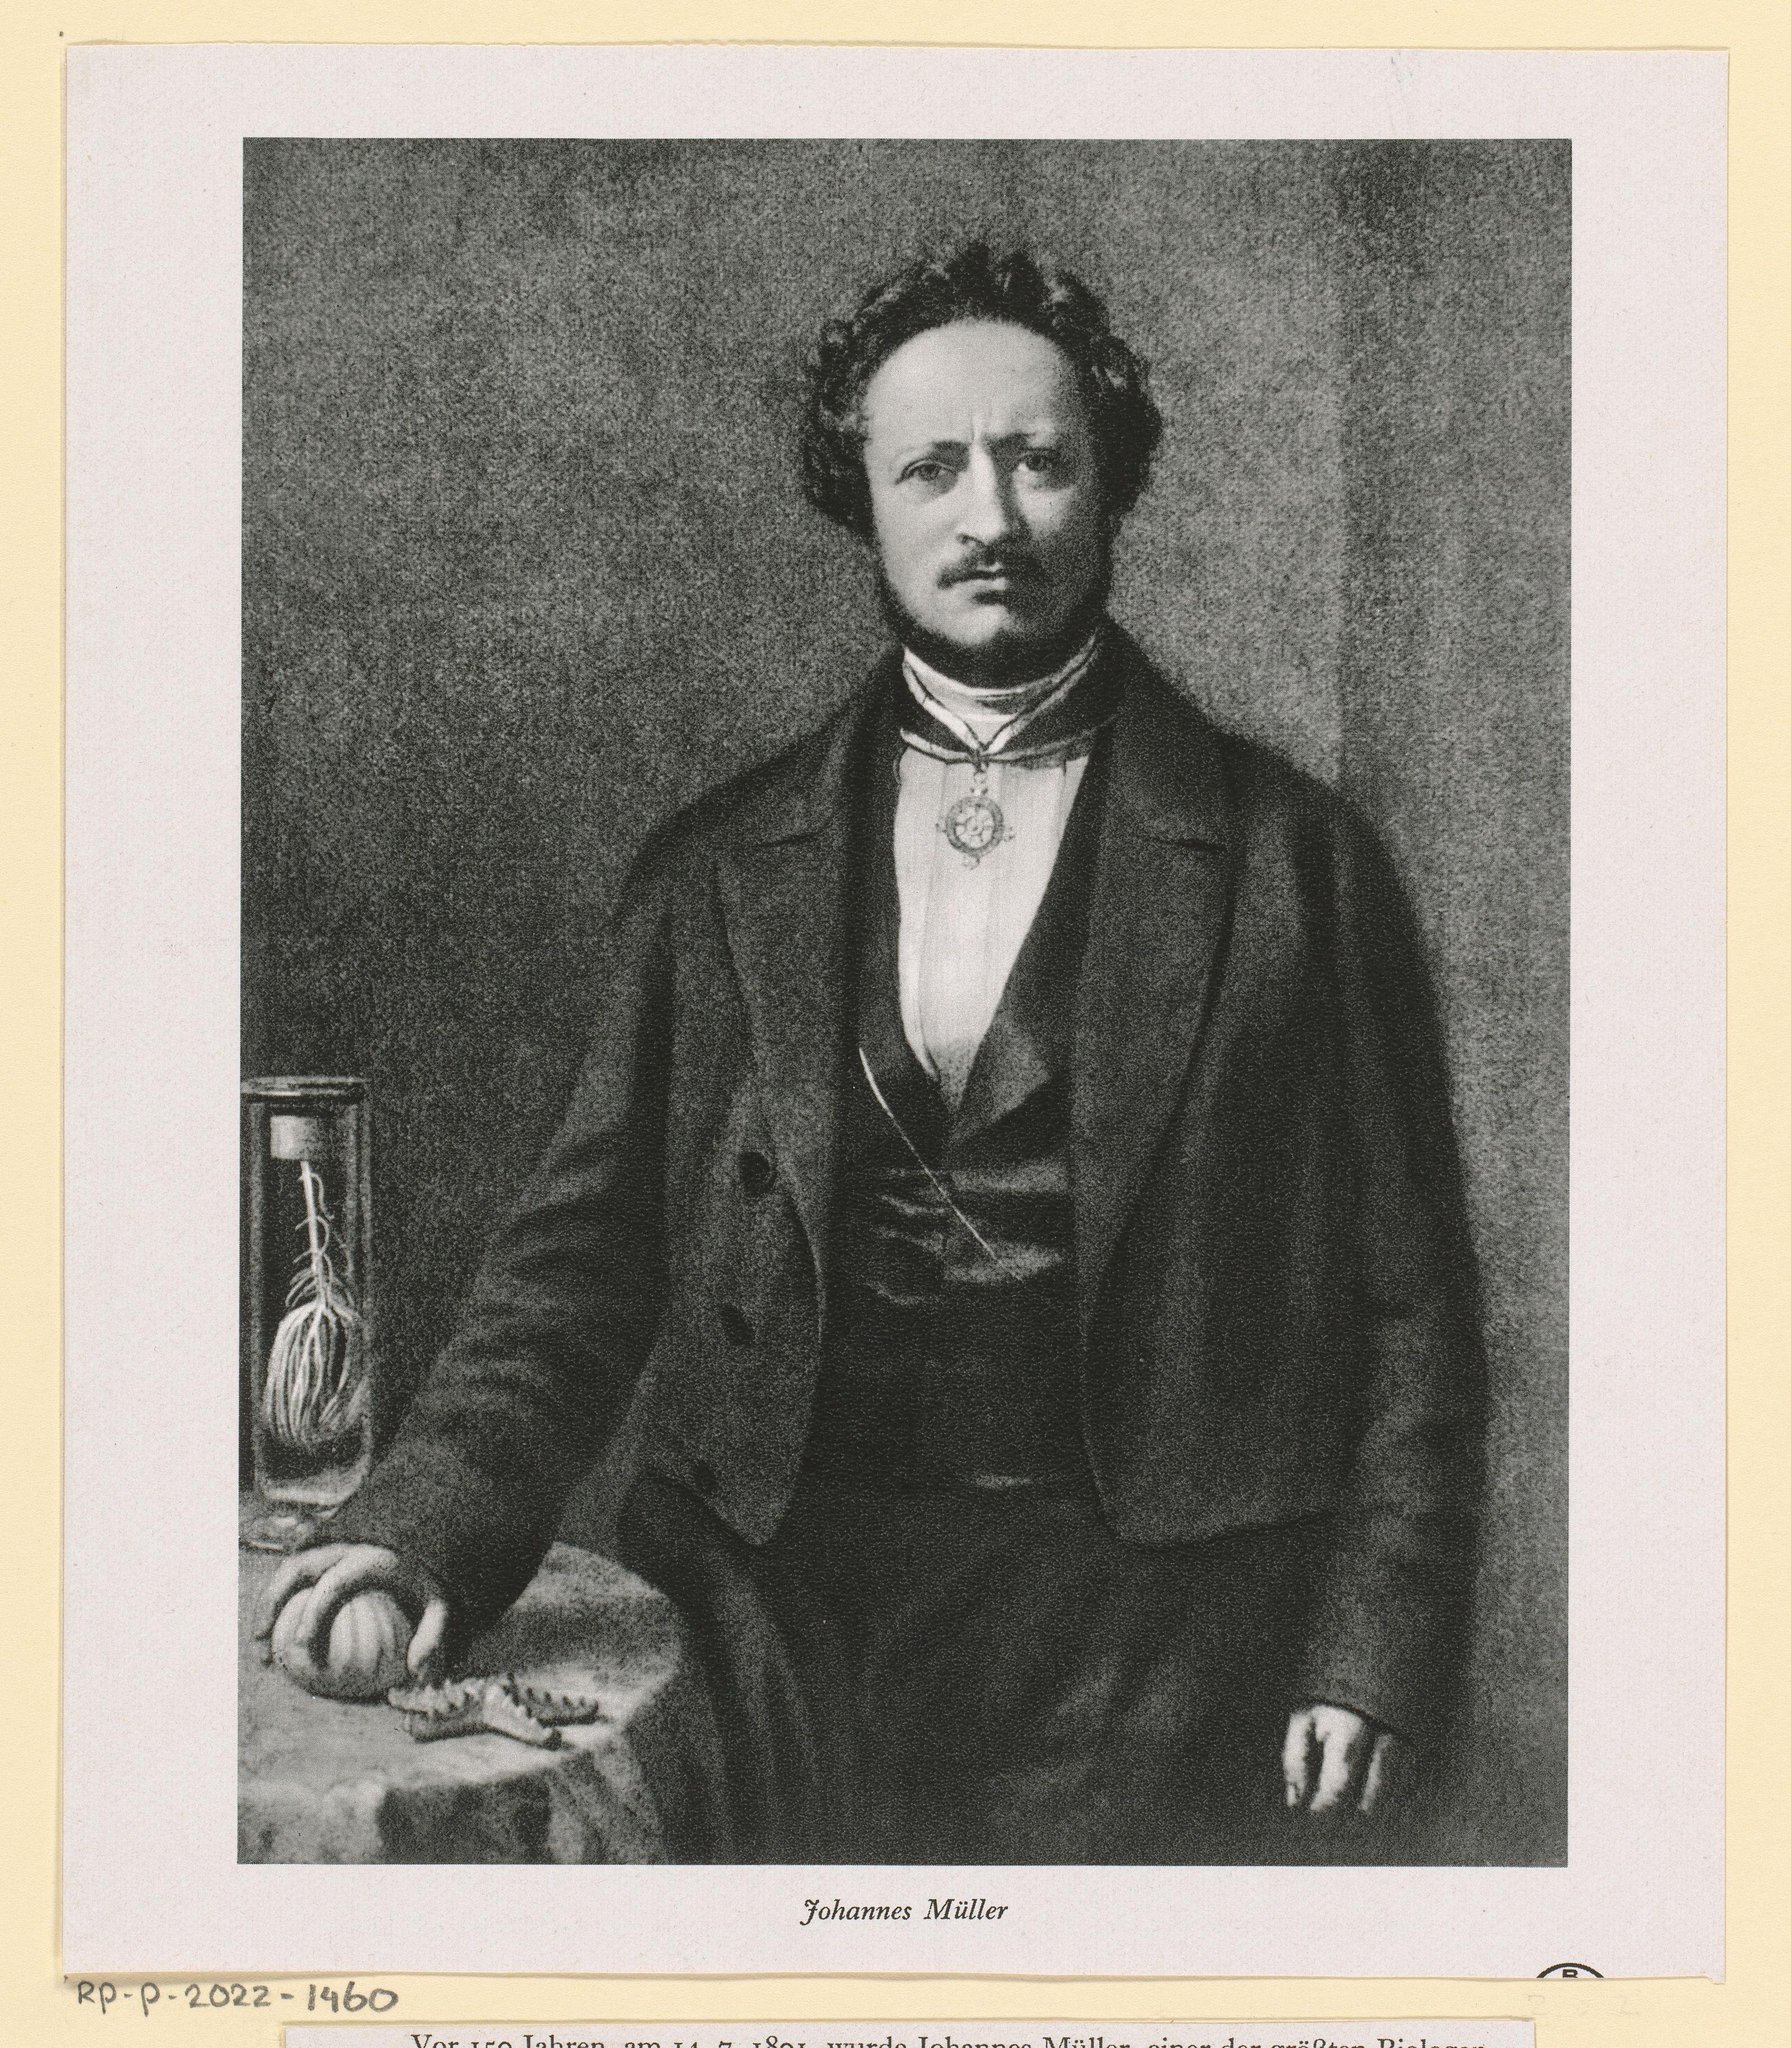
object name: photomechanical print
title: Johannes Müller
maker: Anonymous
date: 1895-2000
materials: paper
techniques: letterpress printing, rotogravure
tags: adult man, historical persons